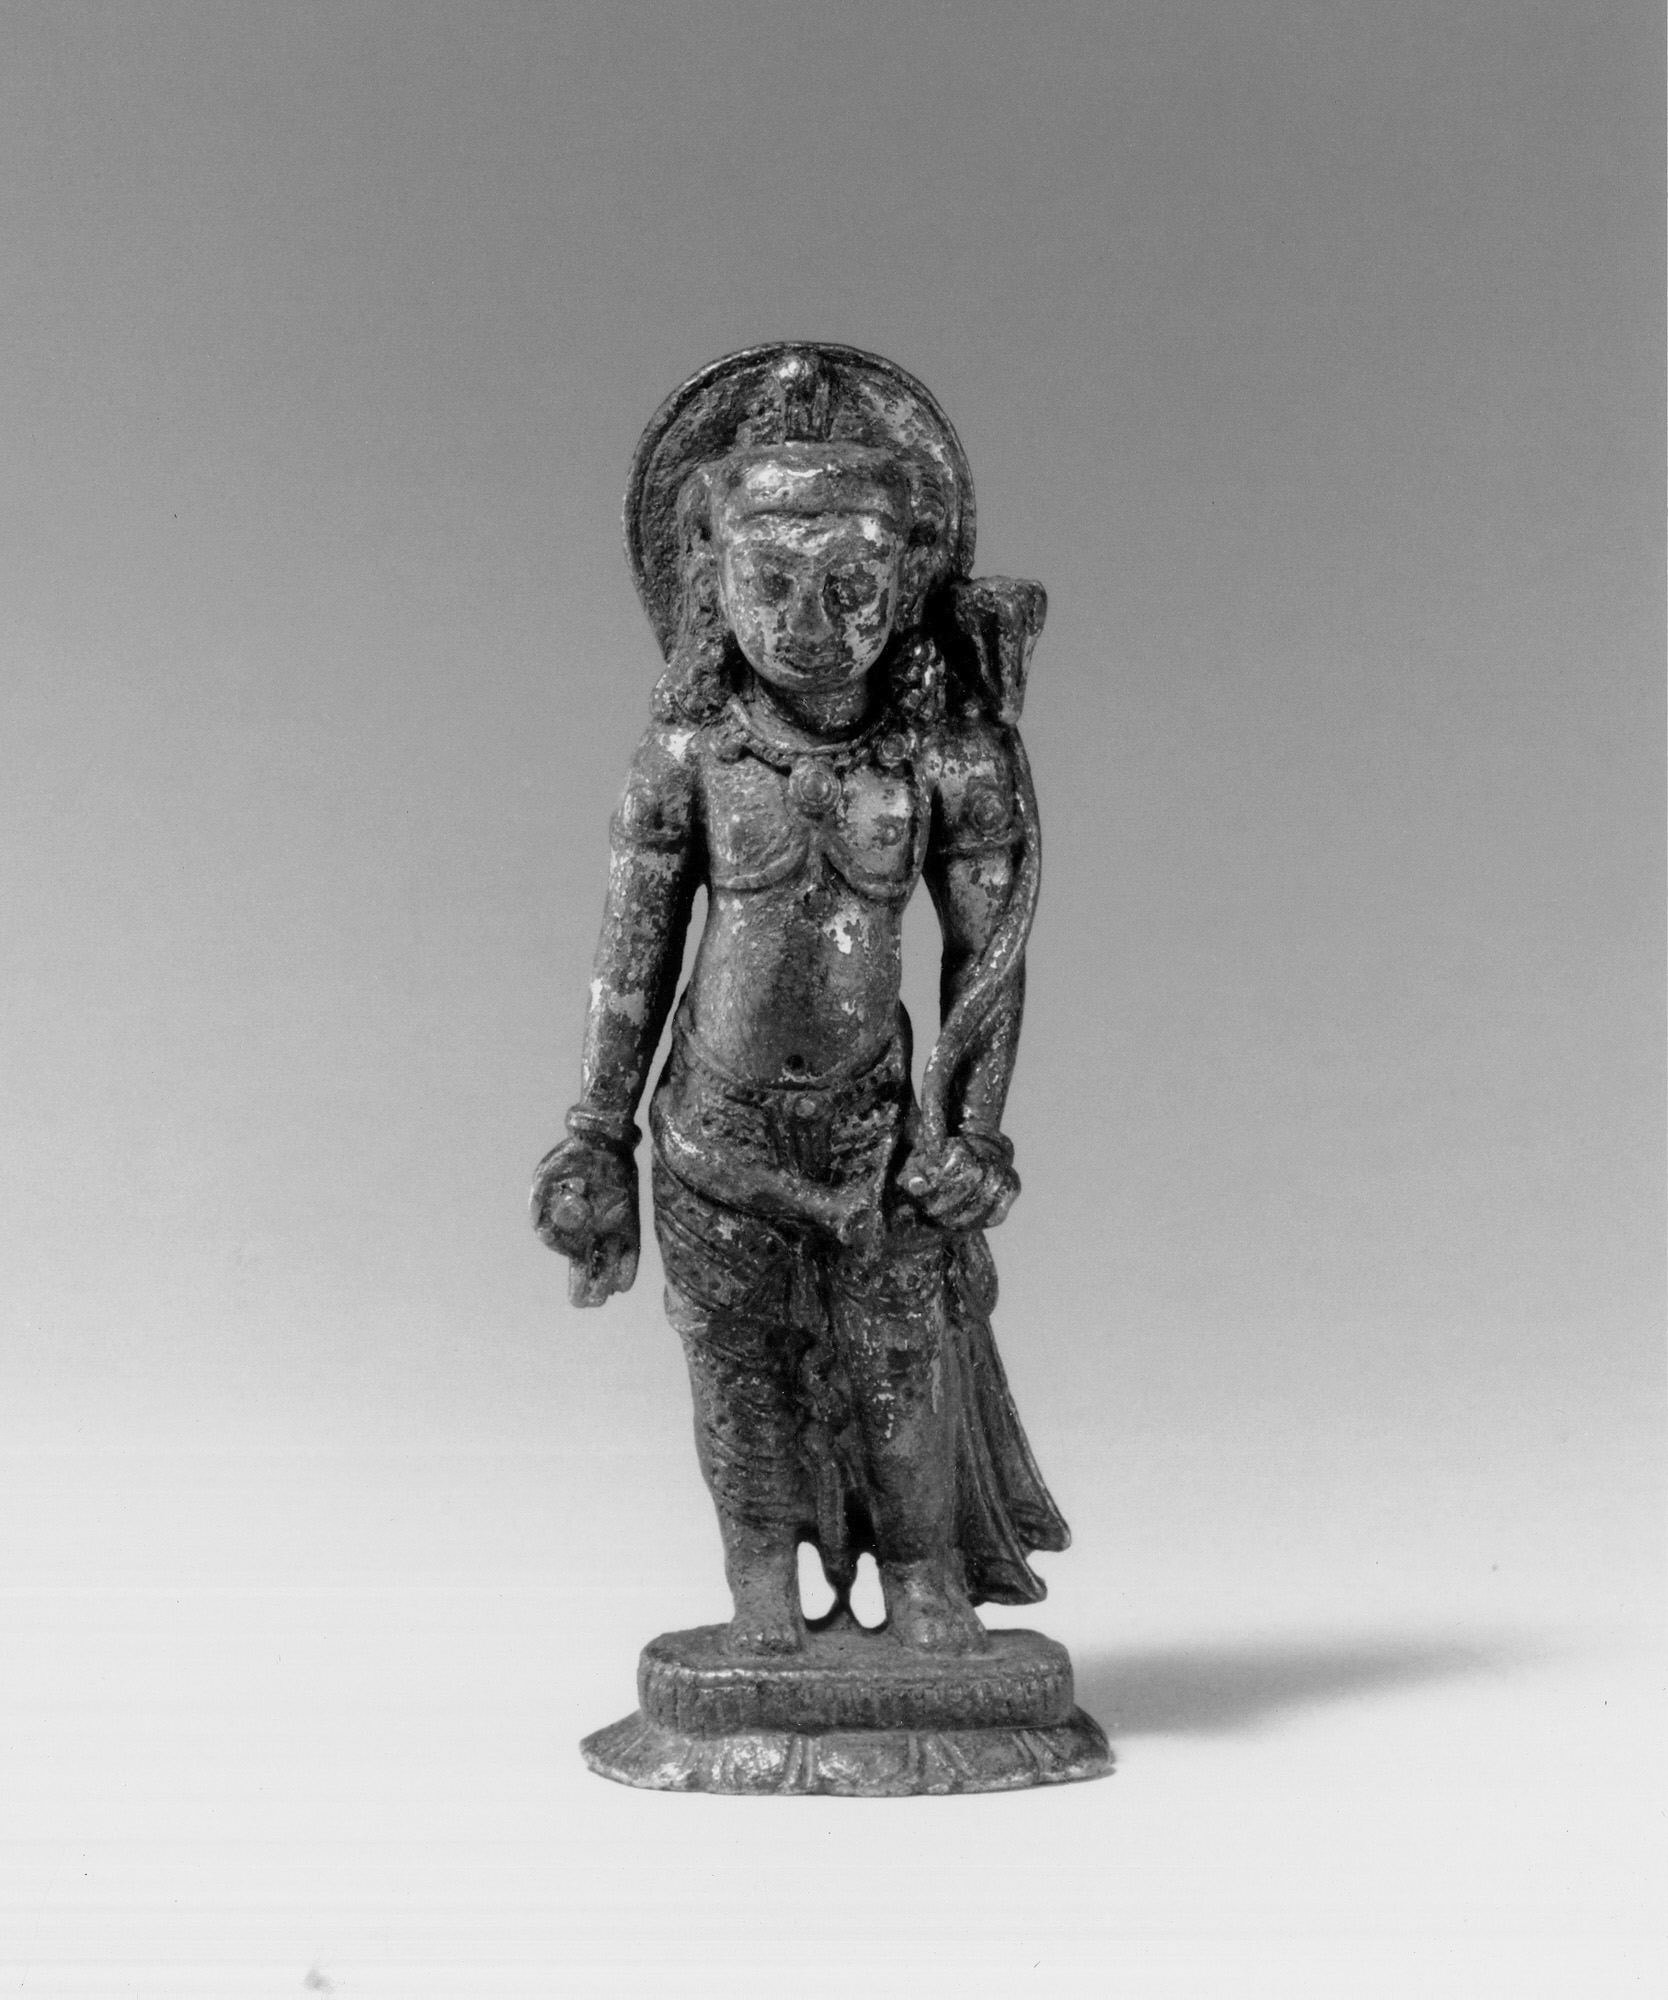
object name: figure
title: Padmapani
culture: nepali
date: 1201-1300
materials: bronze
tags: buddhism,avalokiteshvara,bodhisattvas